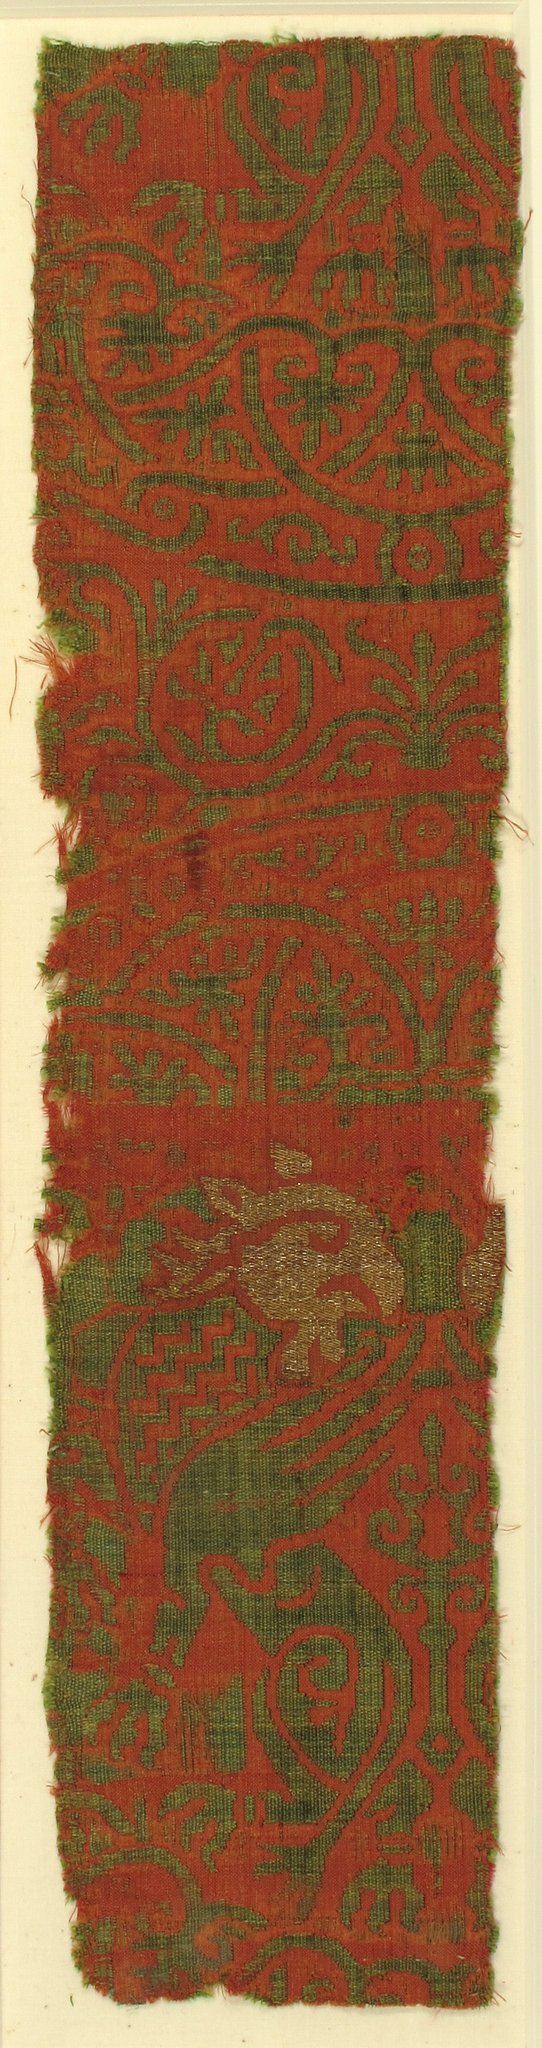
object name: textile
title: Textile with Brocade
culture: spanish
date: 1200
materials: gilt, silk, thread